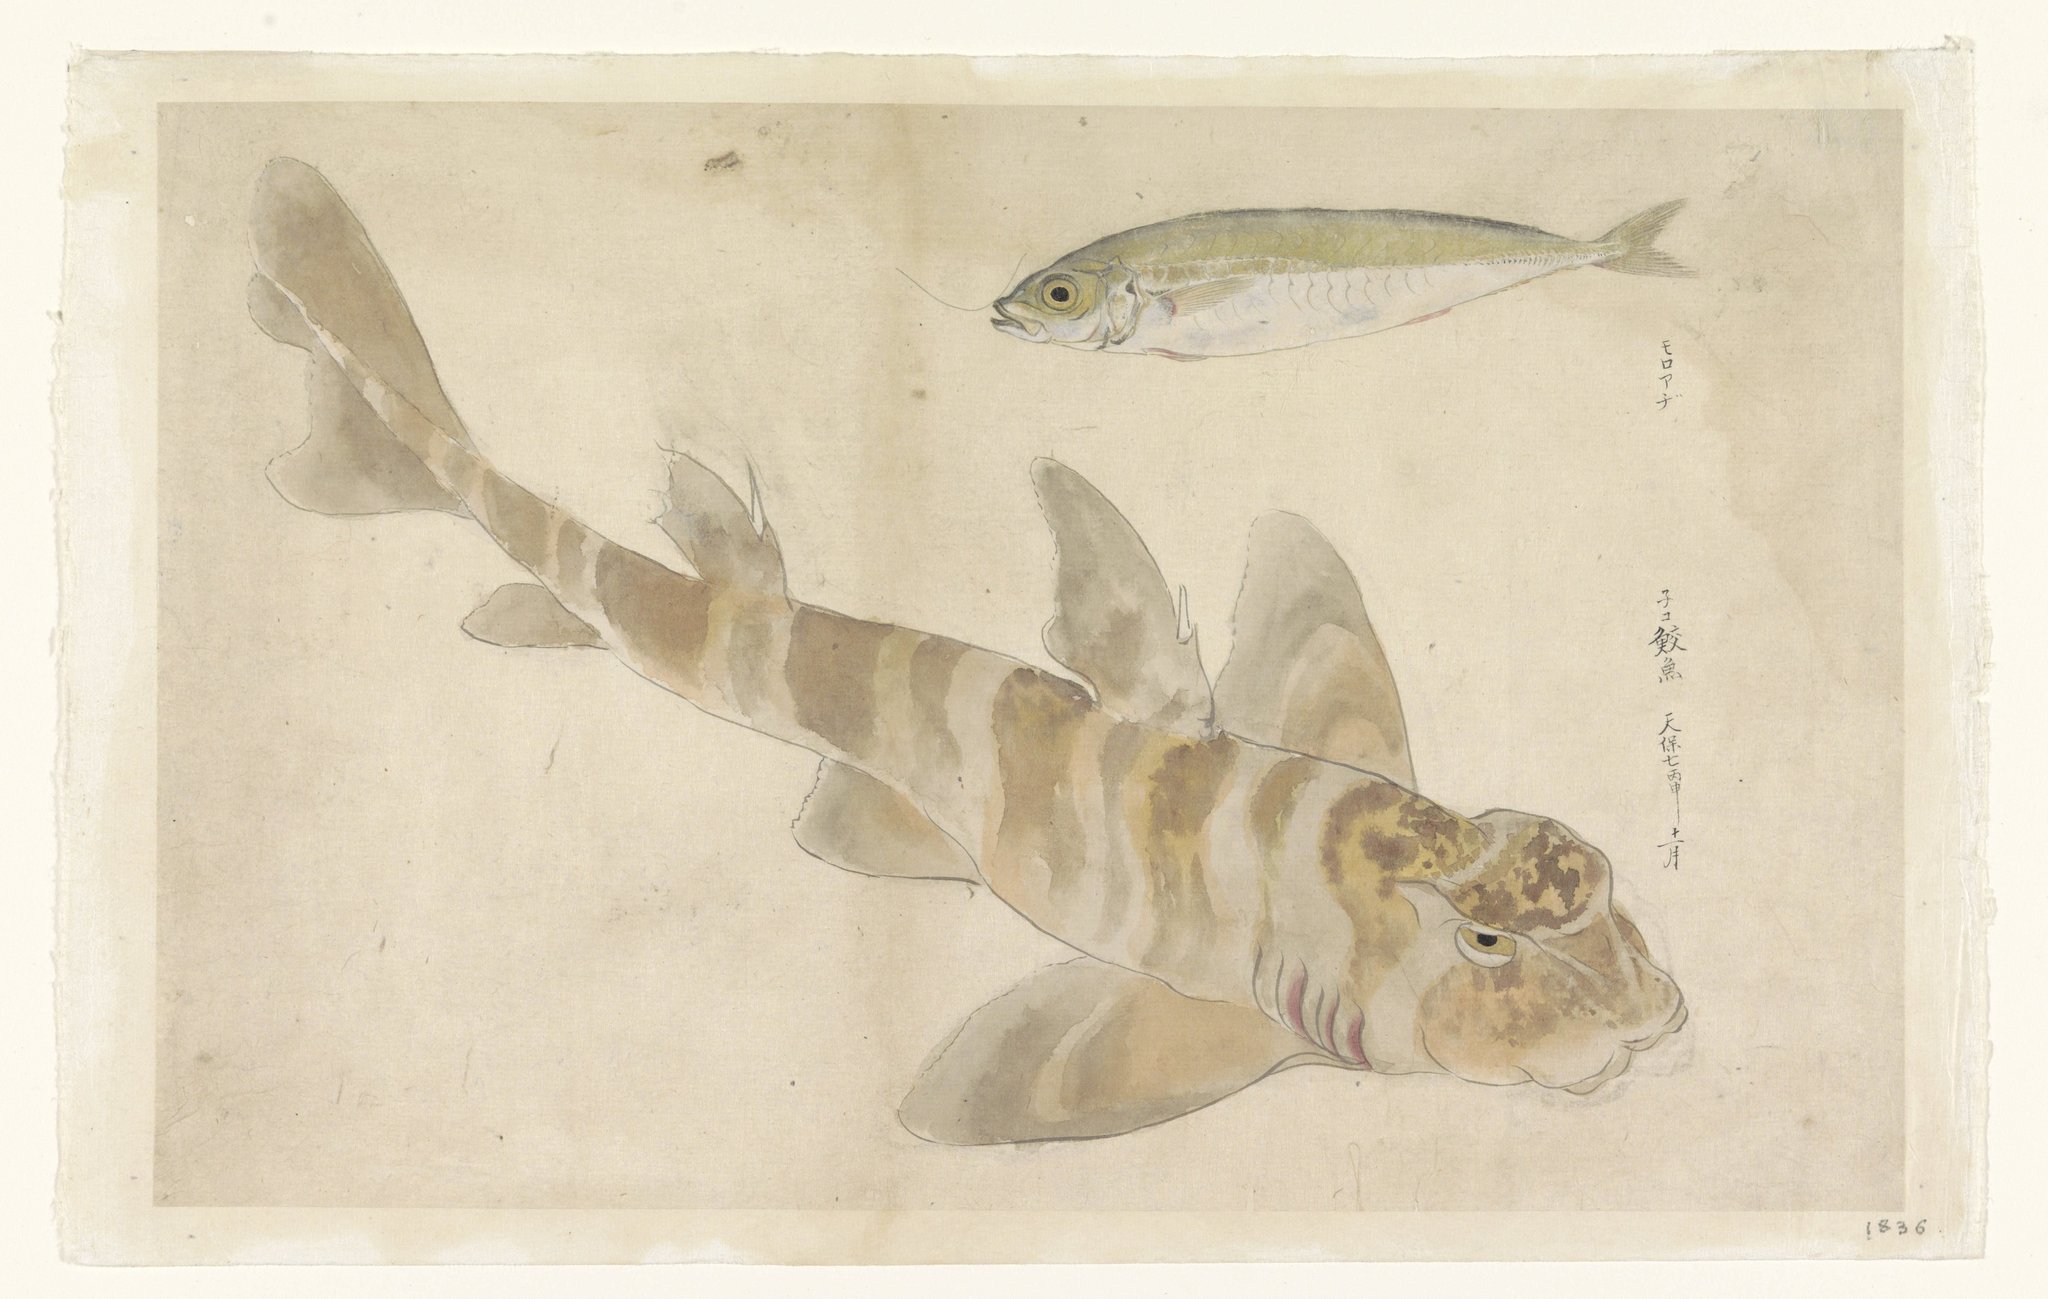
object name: watercolor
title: Twee vissen: poon (?) en haring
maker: ishikawa kazan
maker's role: draughtsman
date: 1836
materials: ink, paper, watercolor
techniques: brush, pen